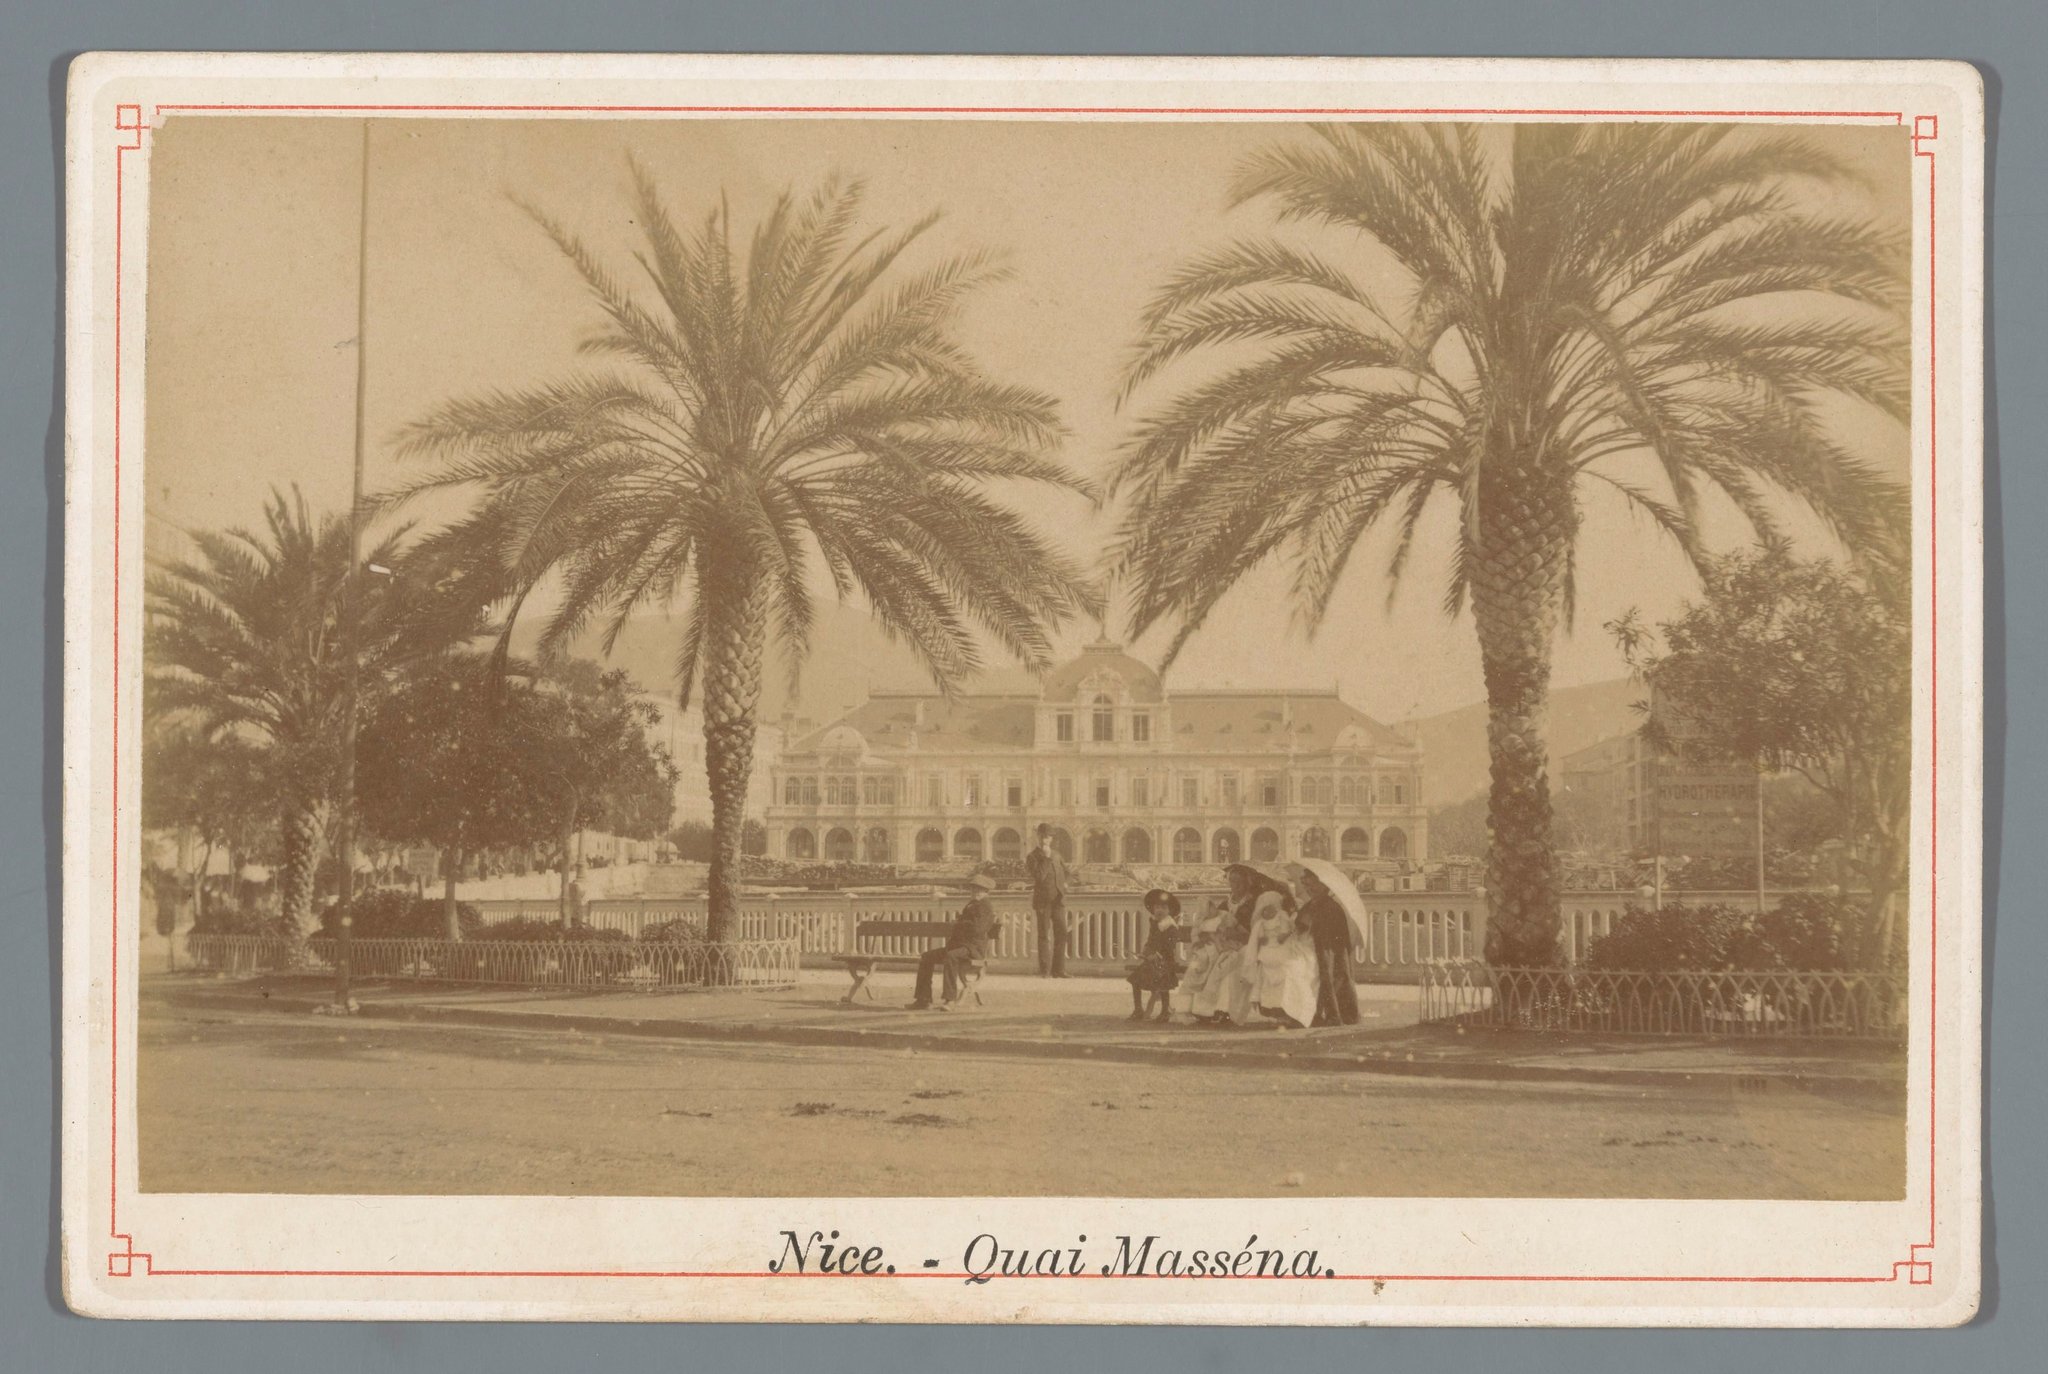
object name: photograph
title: Quai Masséna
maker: Anonymous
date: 1870-1900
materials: cardboard, photographic support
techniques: albumen print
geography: nice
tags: trees: palm-tree, quay